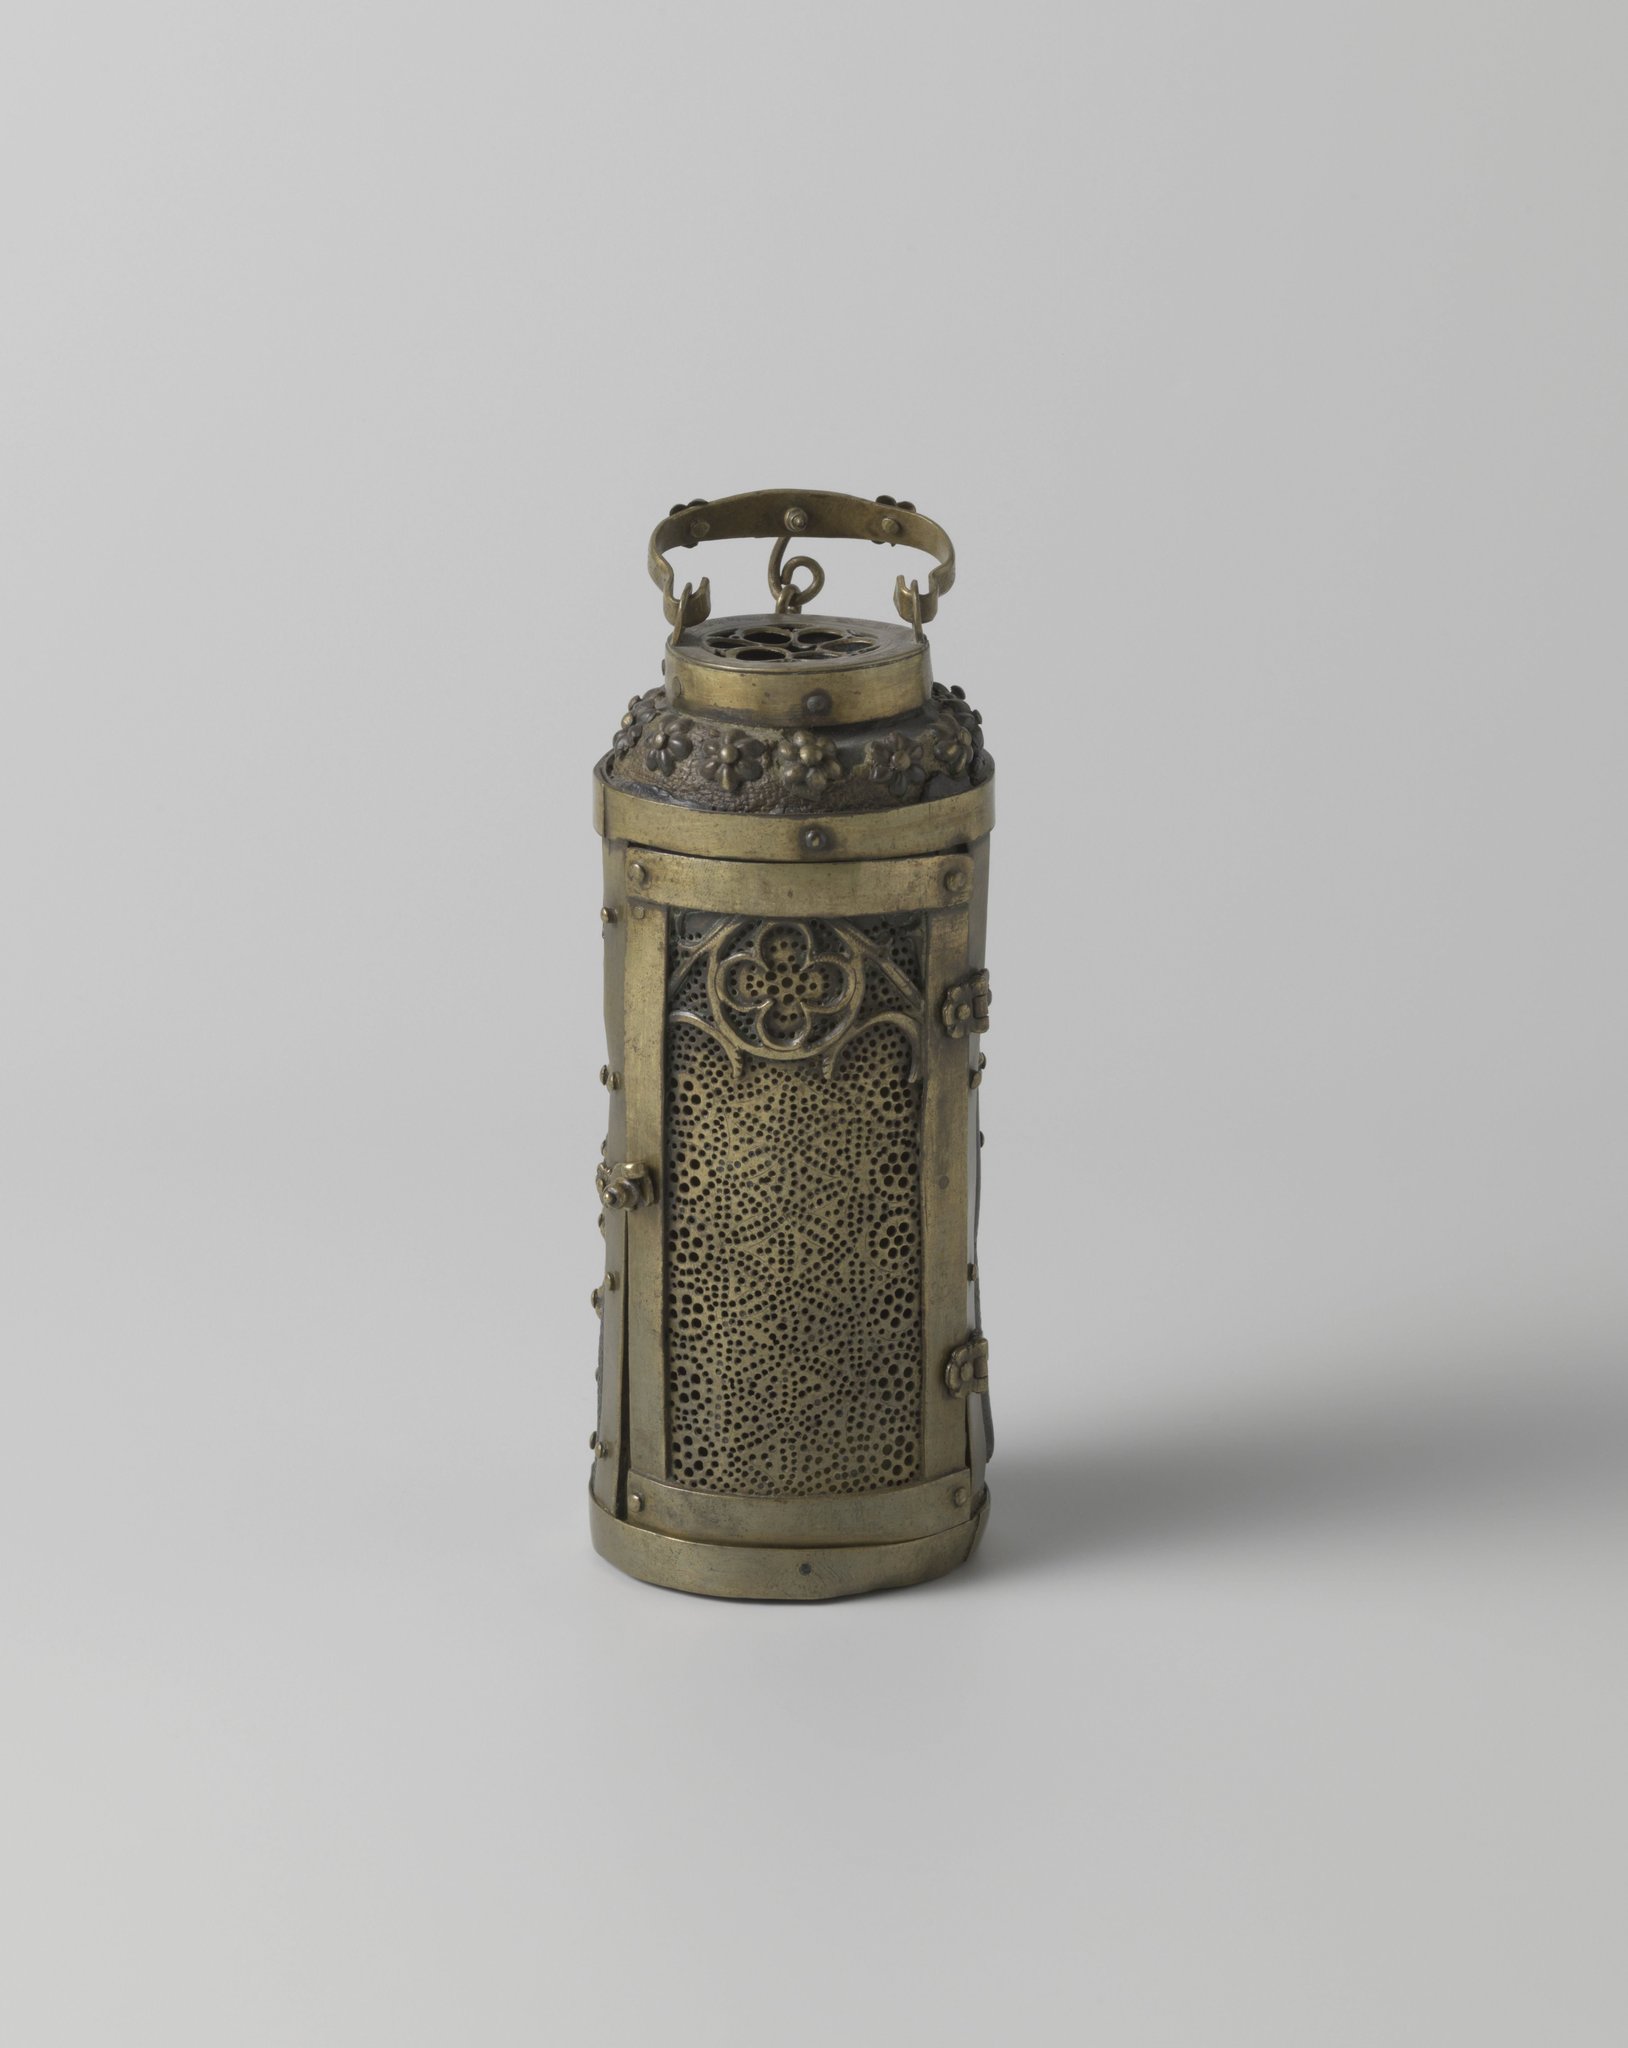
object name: lantern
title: Lantaarn van messing bekleed met robbenvel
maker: Anonymous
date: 1300-1500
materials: brass, leather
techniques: casting, embroidery, riveted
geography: western europe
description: Lantern. Brass, leather. Western Europe, 14th or 15th century.